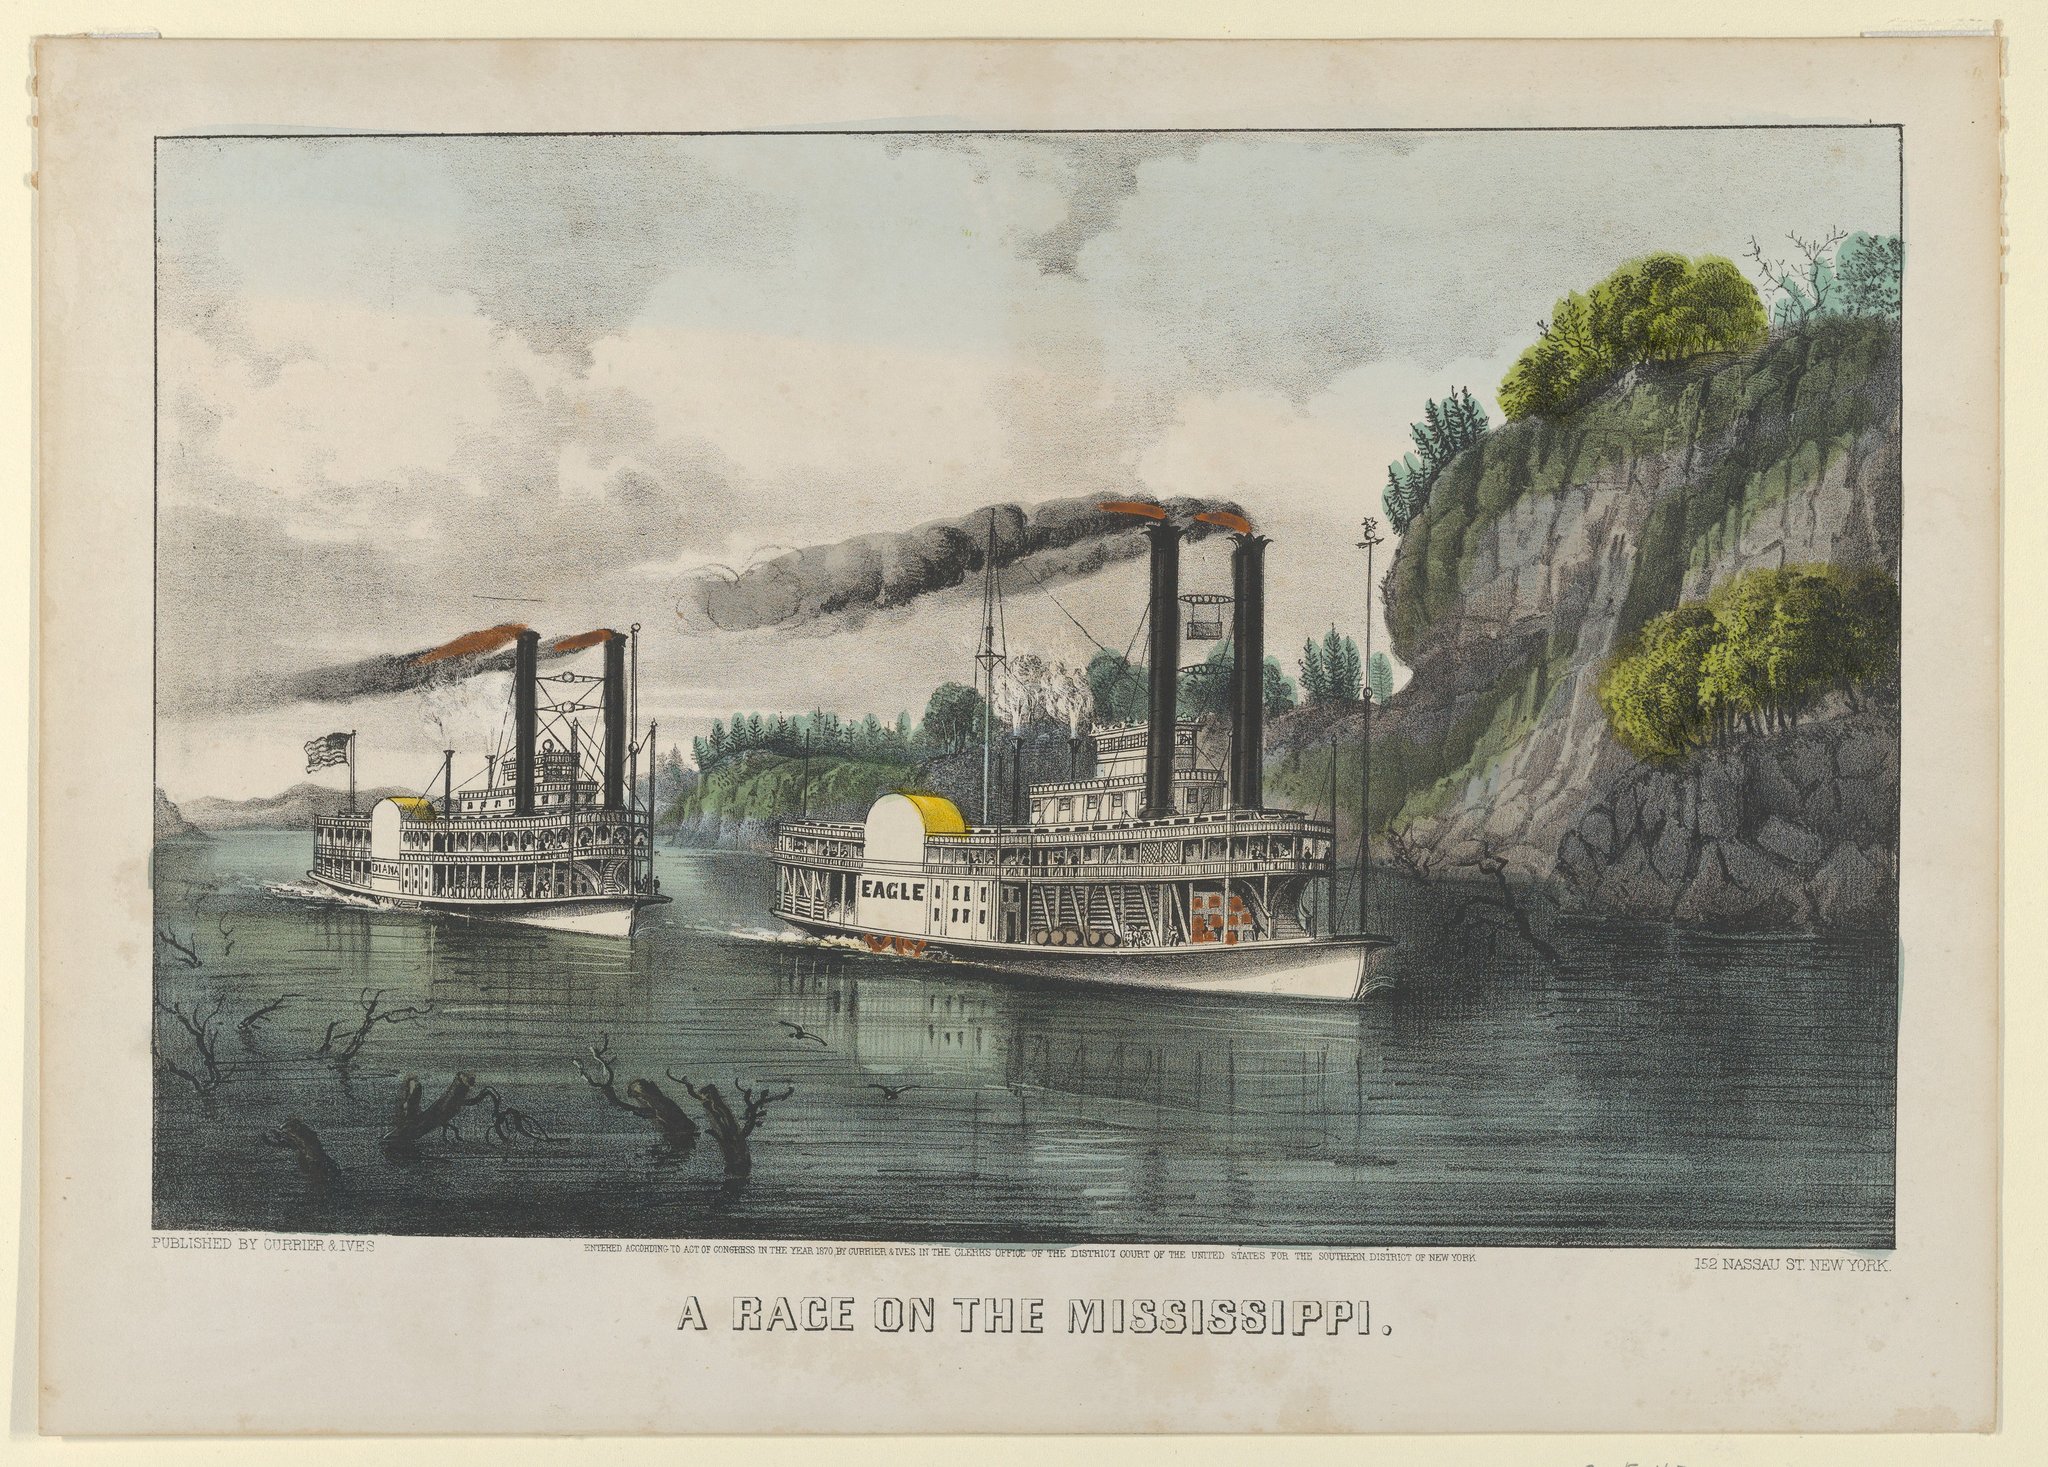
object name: print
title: A Race on the Mississippi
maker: currier & ives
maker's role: lithographer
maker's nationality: american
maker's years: 1857-1907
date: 1870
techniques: hand coloring, lithograph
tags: sports,rivers,ships